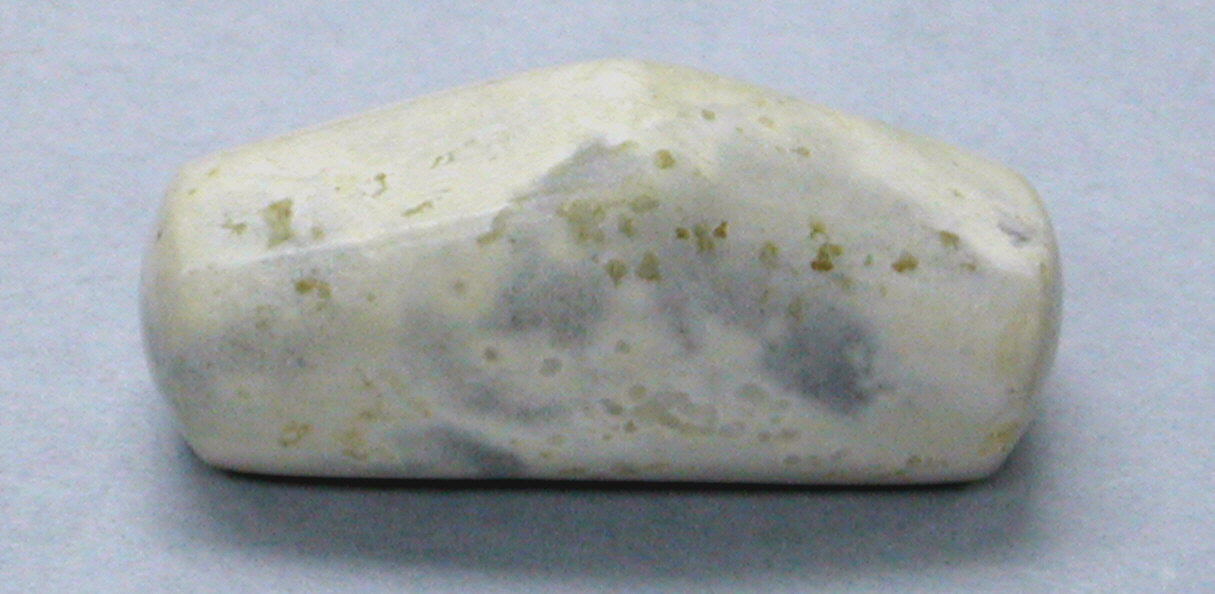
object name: ritual stone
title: Stone Pulidor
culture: mexican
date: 1501-1600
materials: stone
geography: mexico